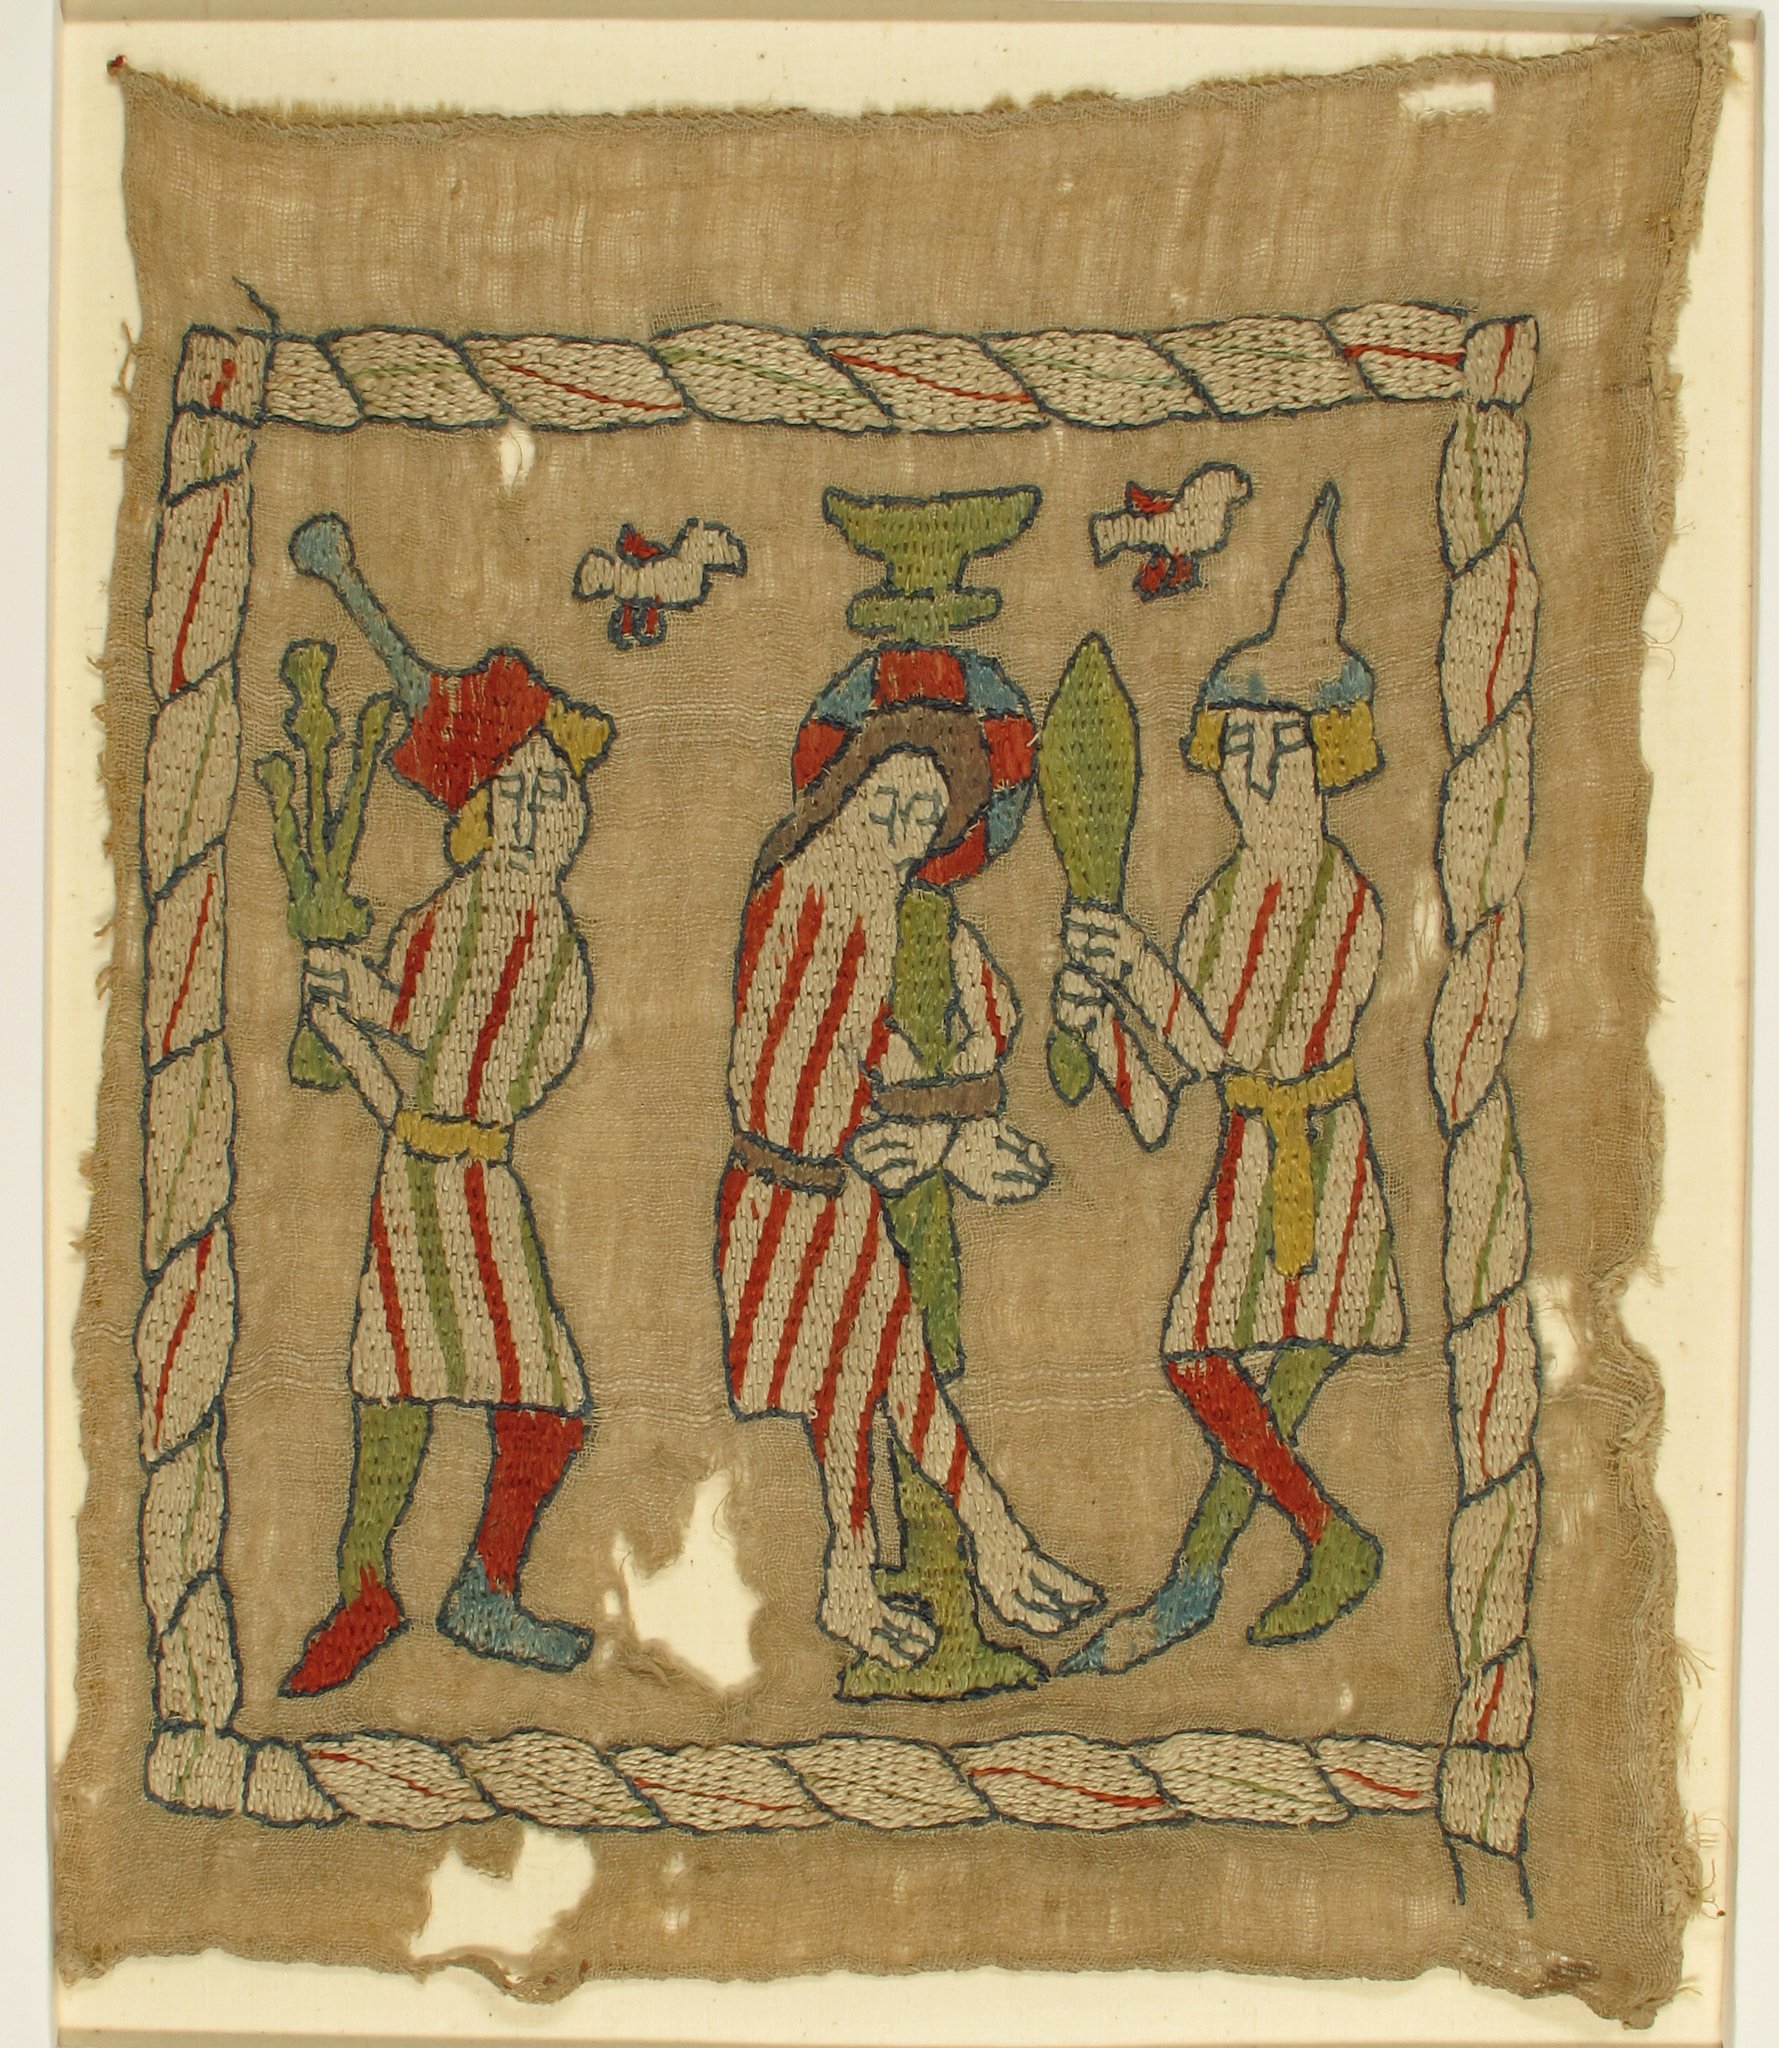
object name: panel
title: Panel depicting Flagellation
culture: german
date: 1301-1400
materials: cotton, wool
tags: birds,christ,flagellation